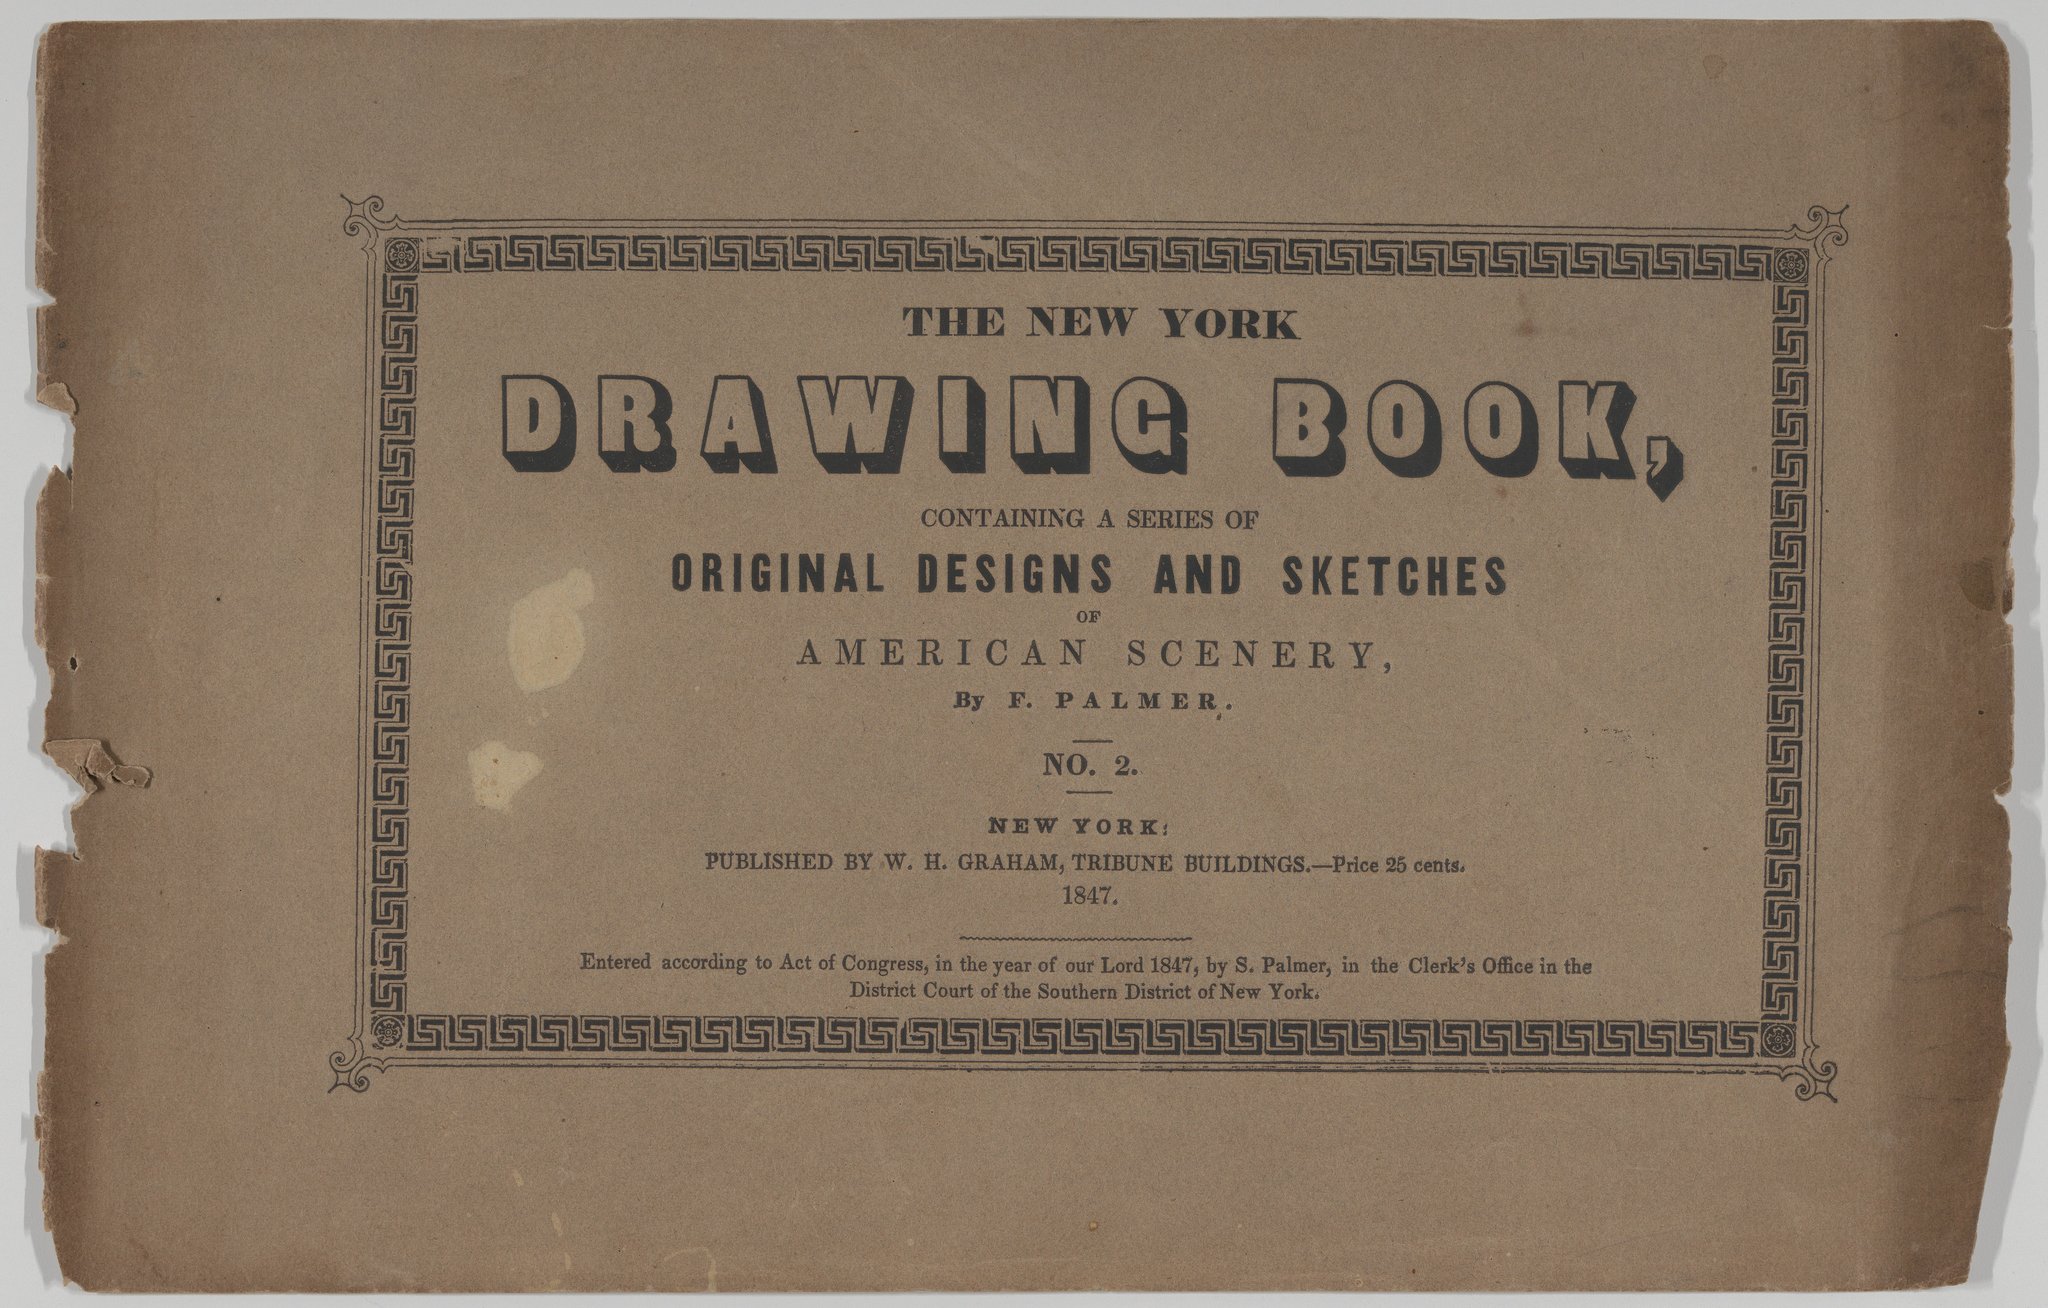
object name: book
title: The New York Drawing Book, Containing a Series of Original Designs and Sketches of American Scenery, by F. Palmer, No. 2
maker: frances flora bond palmer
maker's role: artist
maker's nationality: american, born england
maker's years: 1812-1876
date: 1847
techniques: lithograph